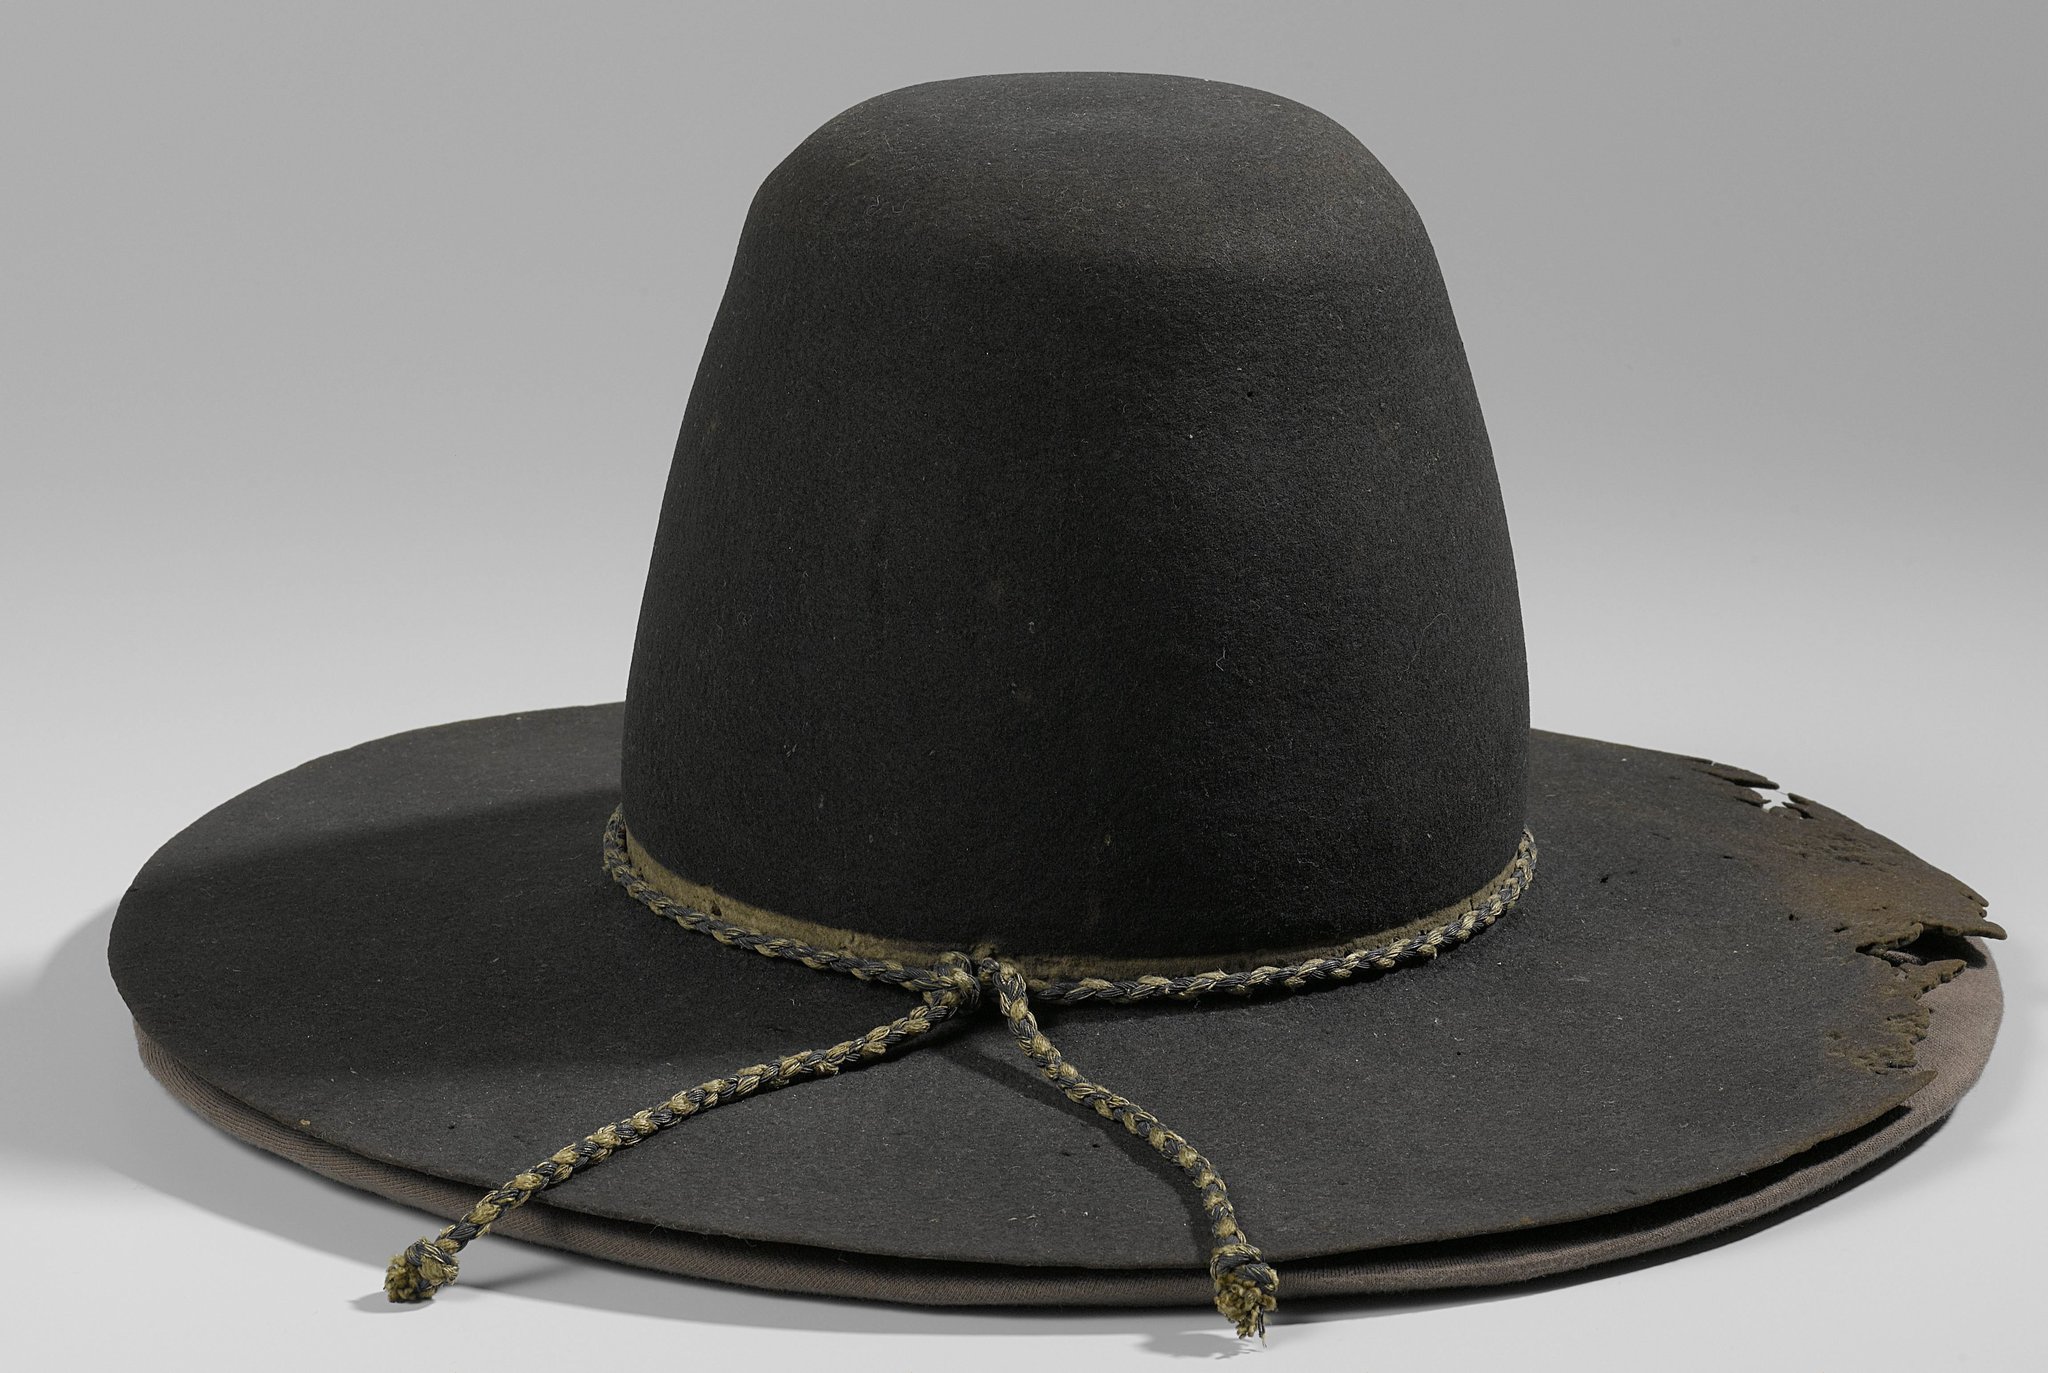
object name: menswear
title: Hat of Hendrik Casimir I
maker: Anonymous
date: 1612-1640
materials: felt, silk, thread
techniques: braiding, forming, pressing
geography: netherlands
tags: arnhem, hendrik casimir i graaf van nassau-dietz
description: Hendrik Casimir was the son of Ernst Casimir. When his father lost his life in 1632, Hendrik succeeded him as stadholder of Friesland, Drenthe, and Groningen. Hendrik also met a violent death: he was shot from his horse in the Flemish city of Hulst in 1640. This is the hat he was wearing at the time. Adjacent to it is the bullet that struck him in the back.